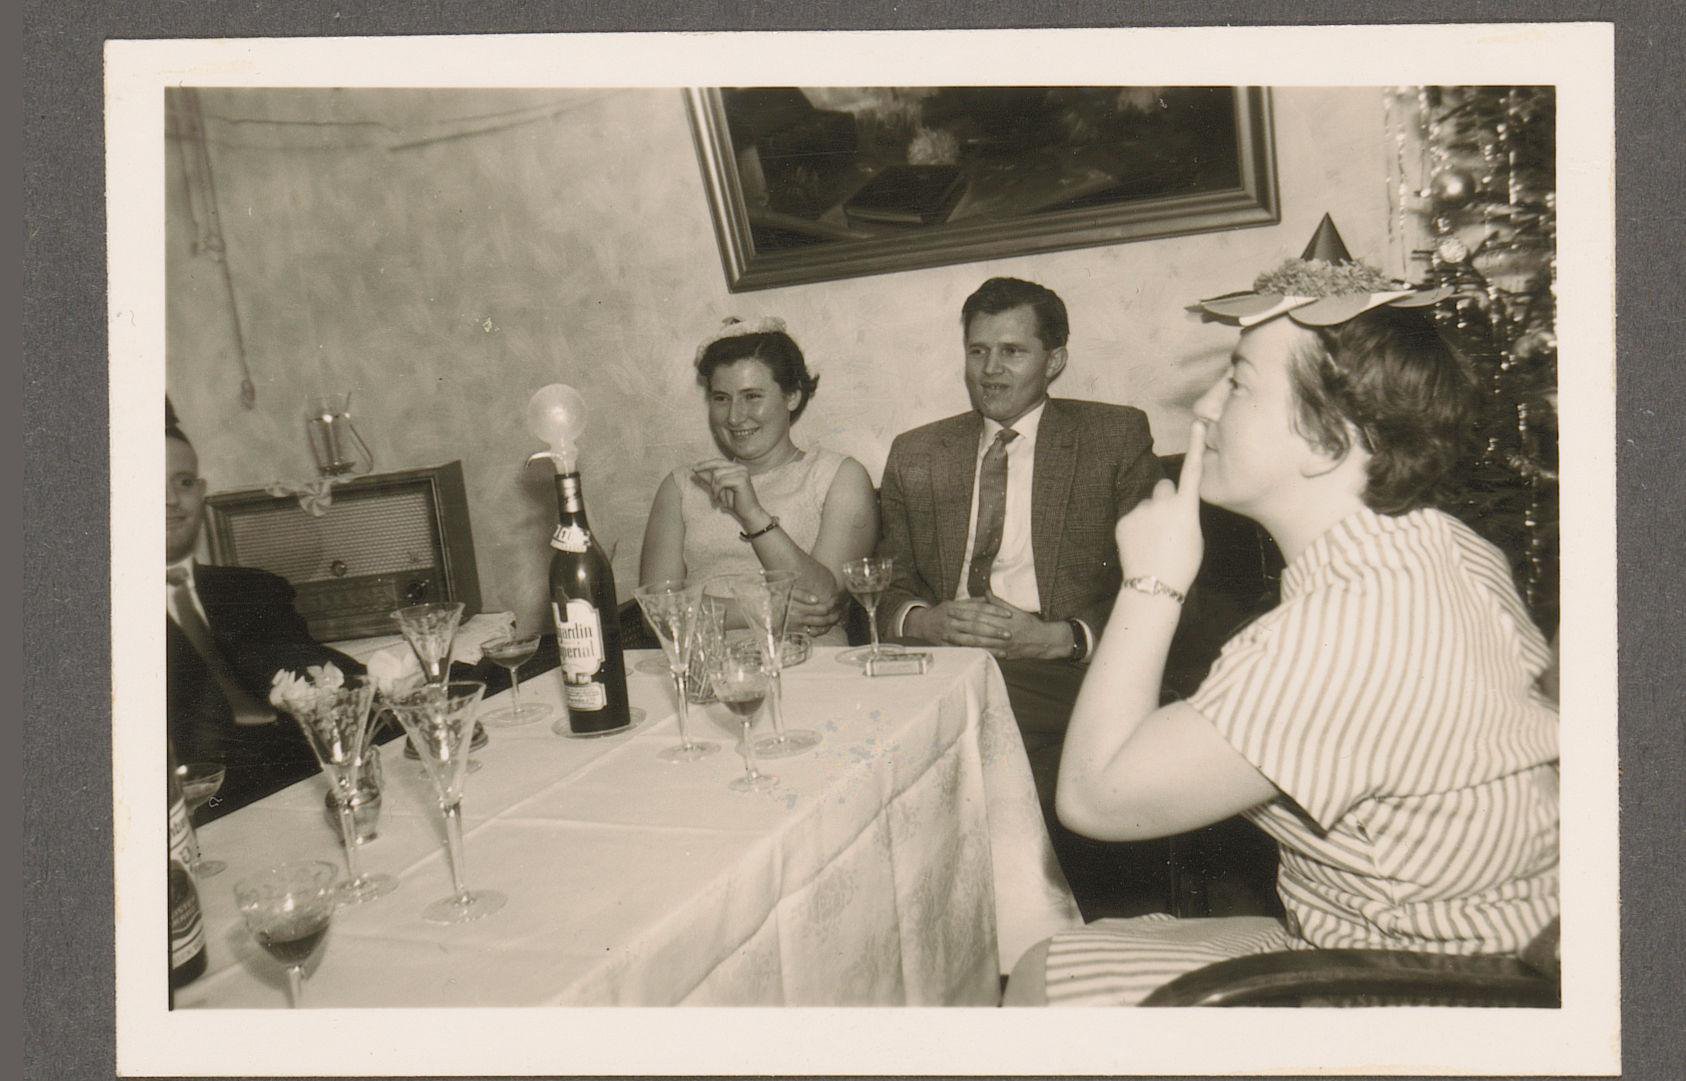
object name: photograph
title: Mannen en vrouwen aan tafel op een feest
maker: Anonymous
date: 1930-1950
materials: paper, photographic support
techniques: gelatin silver print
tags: adult woman, adult man, festivities